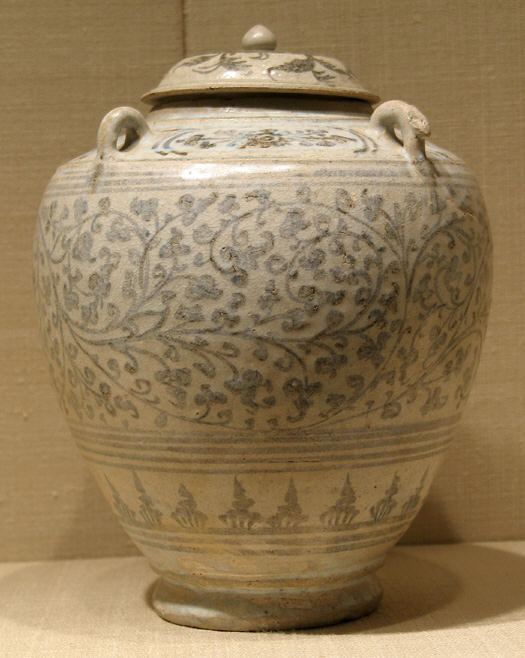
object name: covered jar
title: Covered Jar with Four Lugs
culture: thai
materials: earthenware, glaze, iron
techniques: underglaze